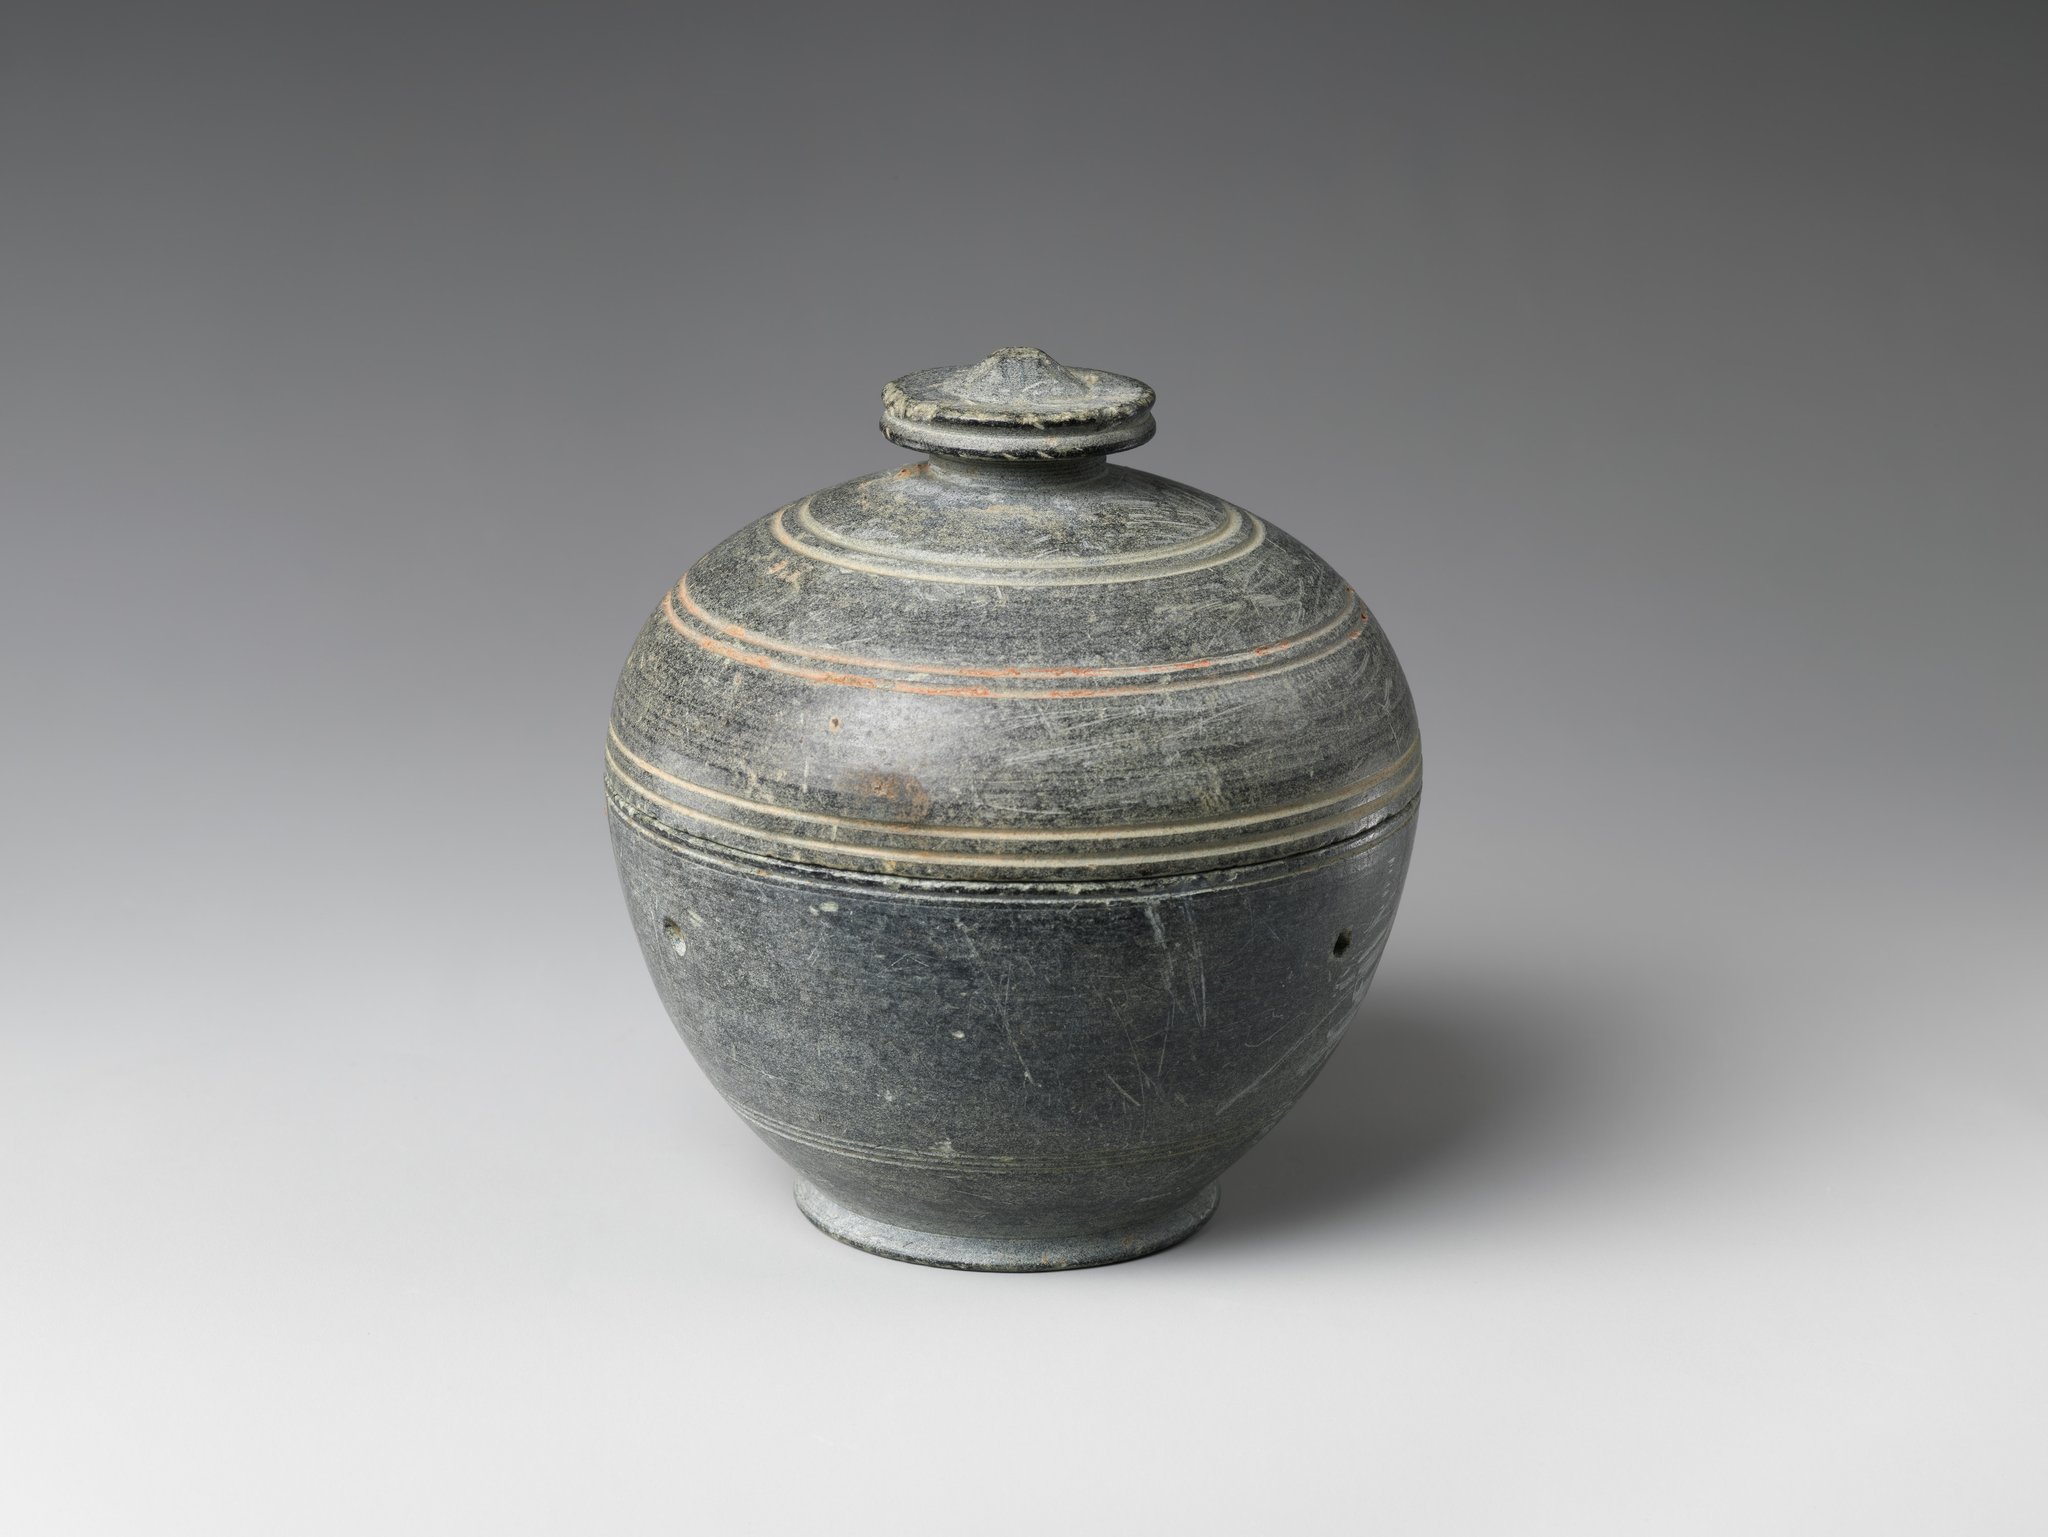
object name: reliquary box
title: Reliquary Box With a Lid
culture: pakistani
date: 1-100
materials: stone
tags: gandhara